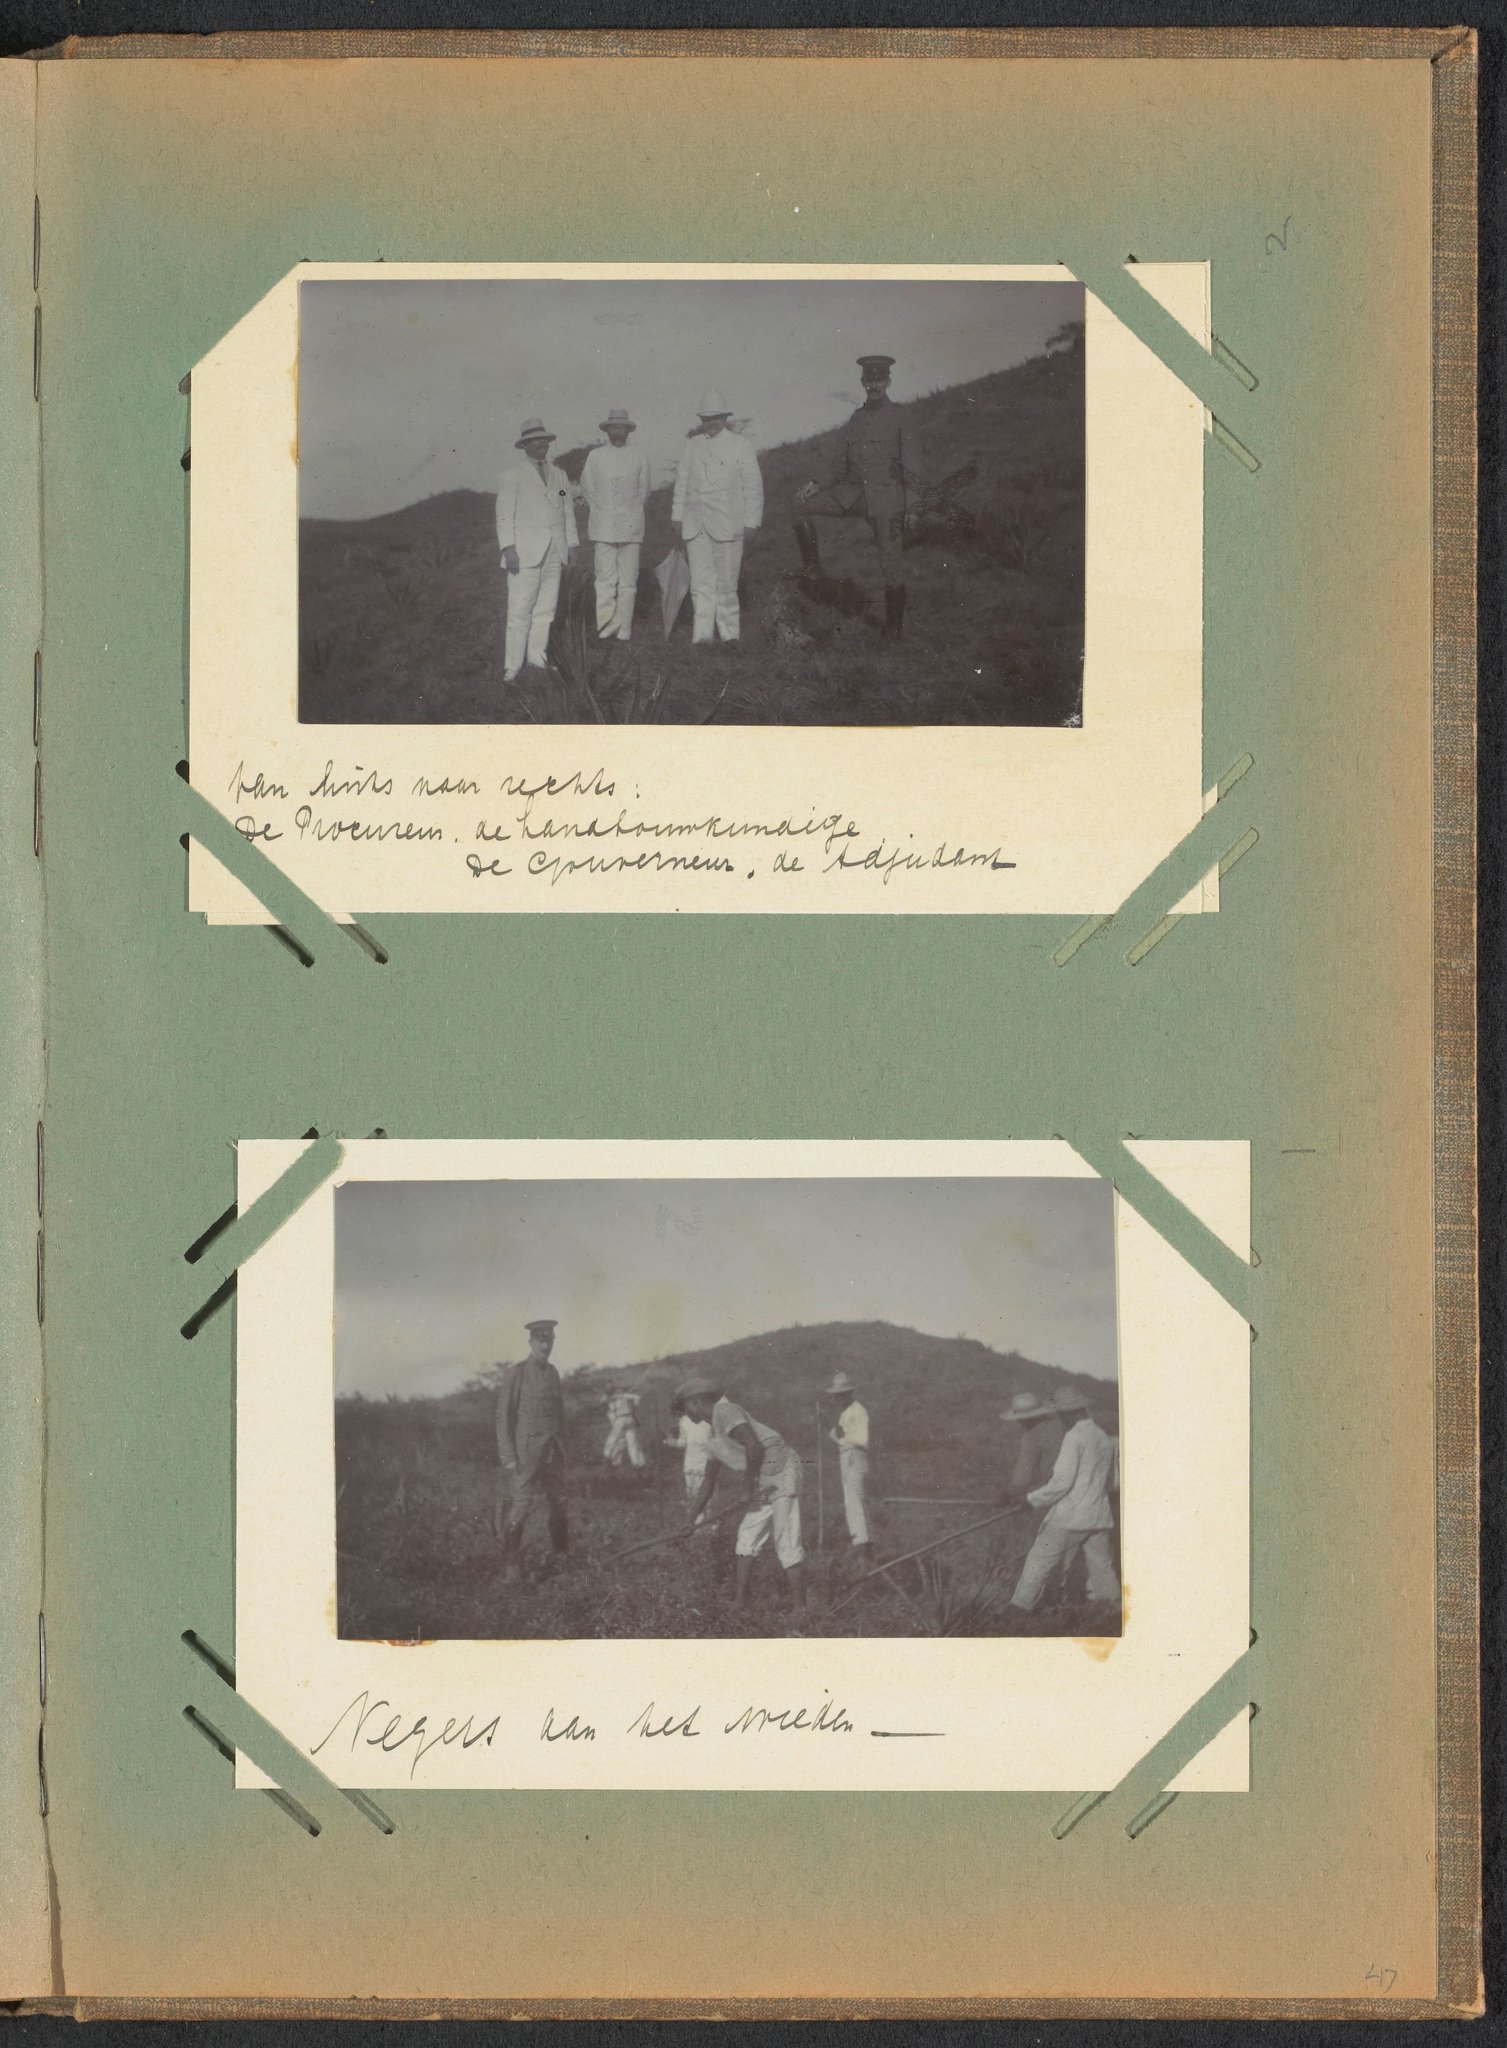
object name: photograph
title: van links naar rechts: De Procureur, de Landbouwkundige, de Gouverneur, de Adjudant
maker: Anonymous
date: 1912-1913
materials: paper, photographic support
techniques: gelatin silver print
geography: curacao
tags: plantation, (non-fruit) products of plants or trees: sisal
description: Groepsfoto bij het bezoek van de gouverneur Nuijens aan de sisalplantage Mount Pleasant op Curaçao. Onderdeel van het fotoalbum uit ca. 1912-1913 met 92 foto's van de plantages Peperpot en Dordrecht in Suriname en Mount Pleasant op Curaçao.